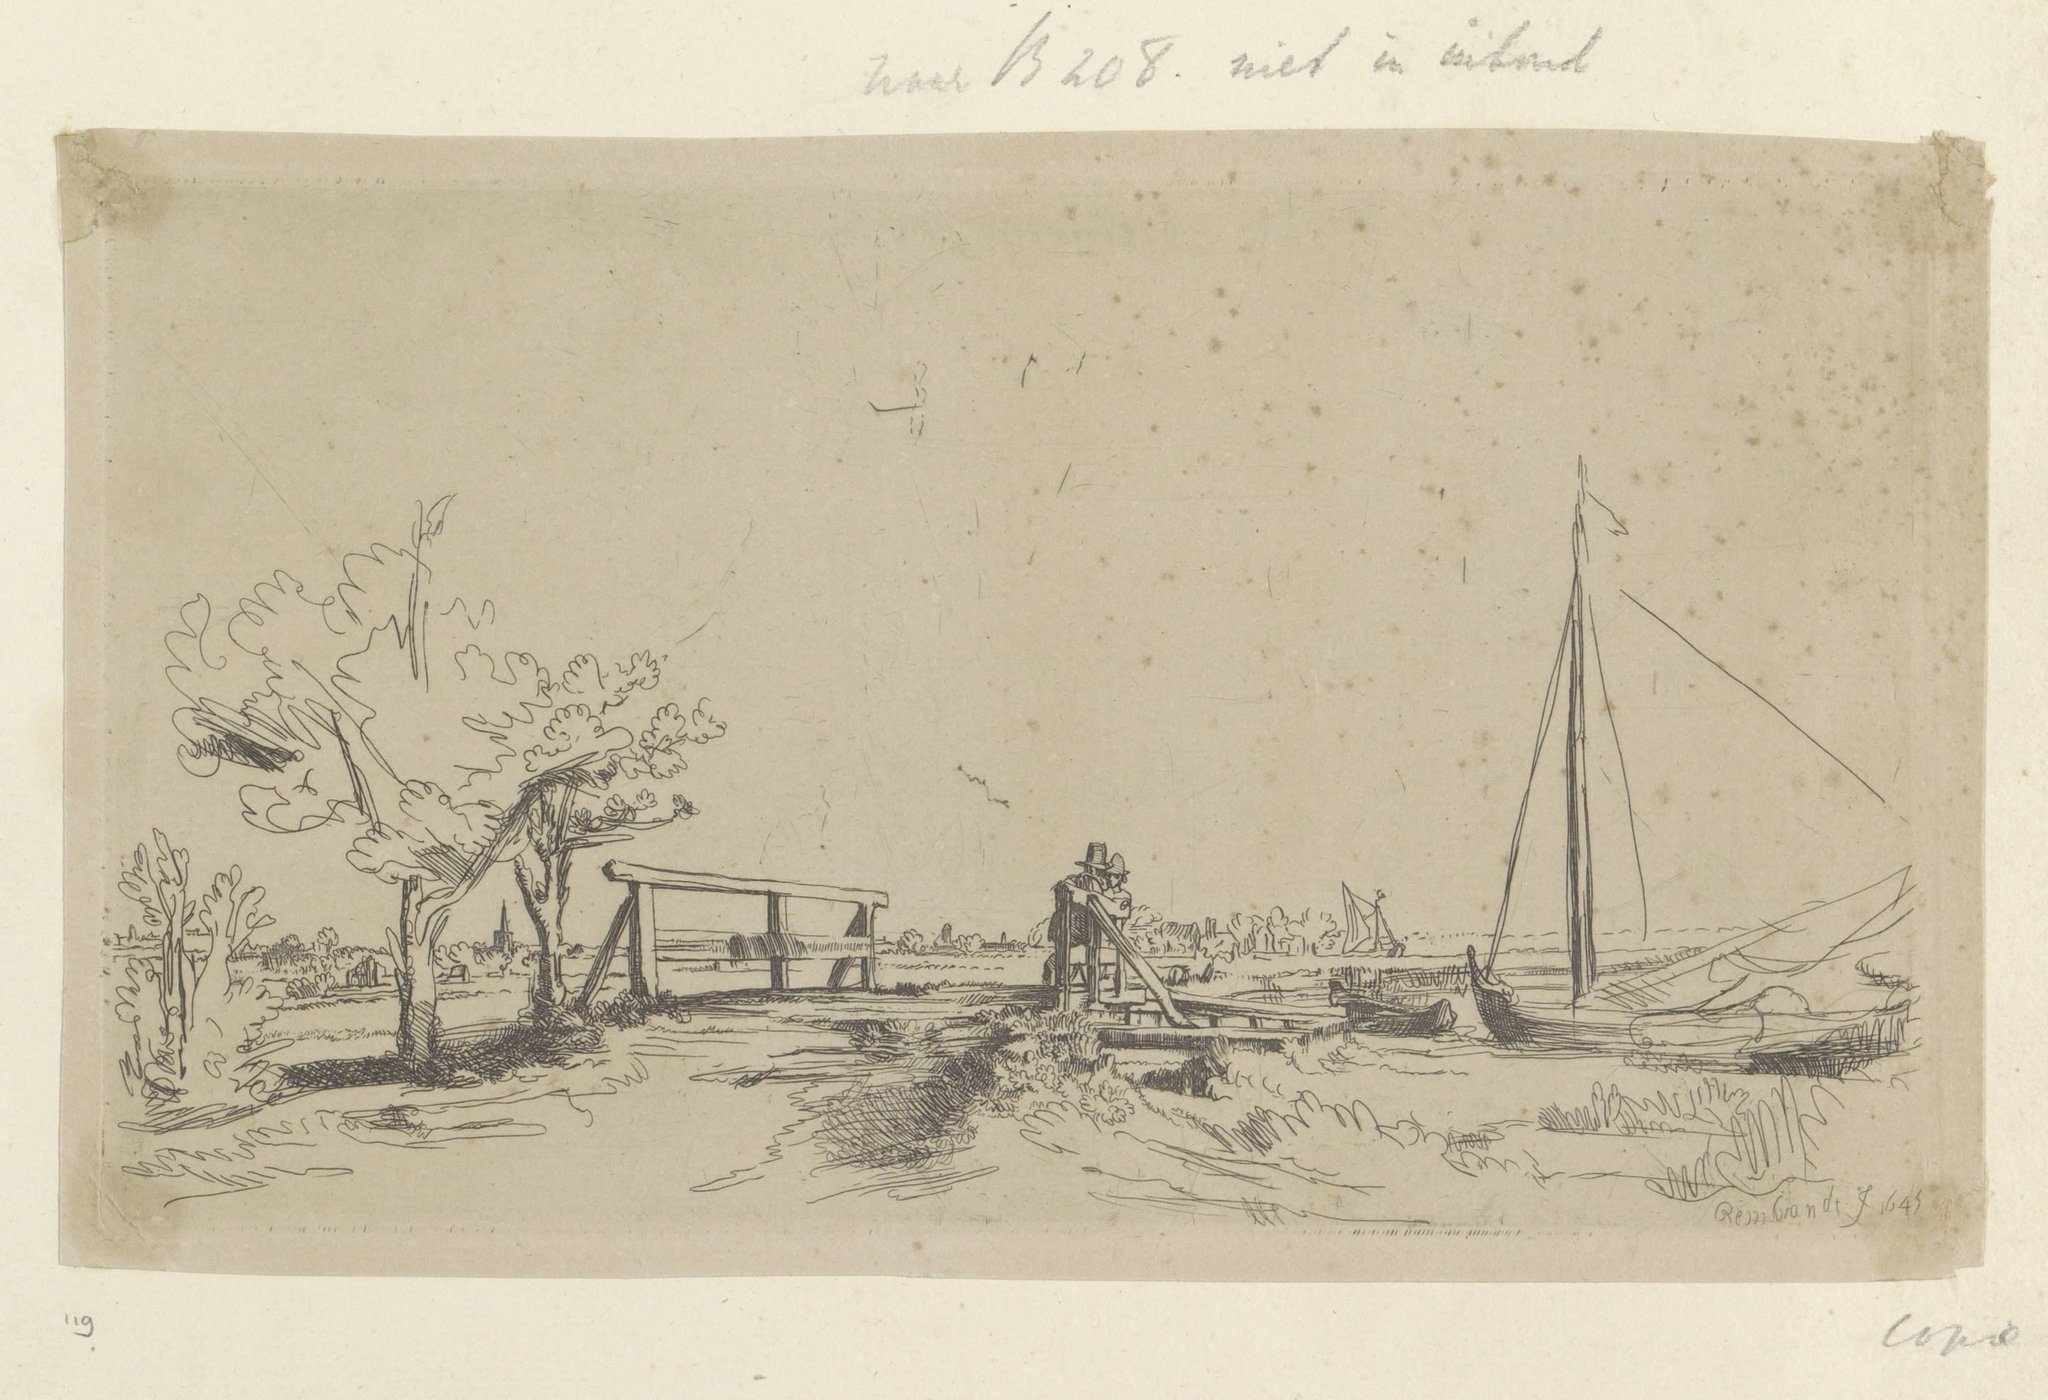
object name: print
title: The bridge at Klein Kostverloren on the Amstel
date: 1776-1807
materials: paper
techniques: etching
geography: paris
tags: landscape with bridge, viaduct or aqueduct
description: De precieze locatie van de voorstelling is onduidelijk. Lang werd het geduid als een bruggetje bij buitenplaats Klein-Kostverloren met gezicht op Ouderkerk aan de Amstel, maar het zou ook aan de Bullewijk onder Ouderkerk kunnen zijn (zie documentatie, De Winkel).